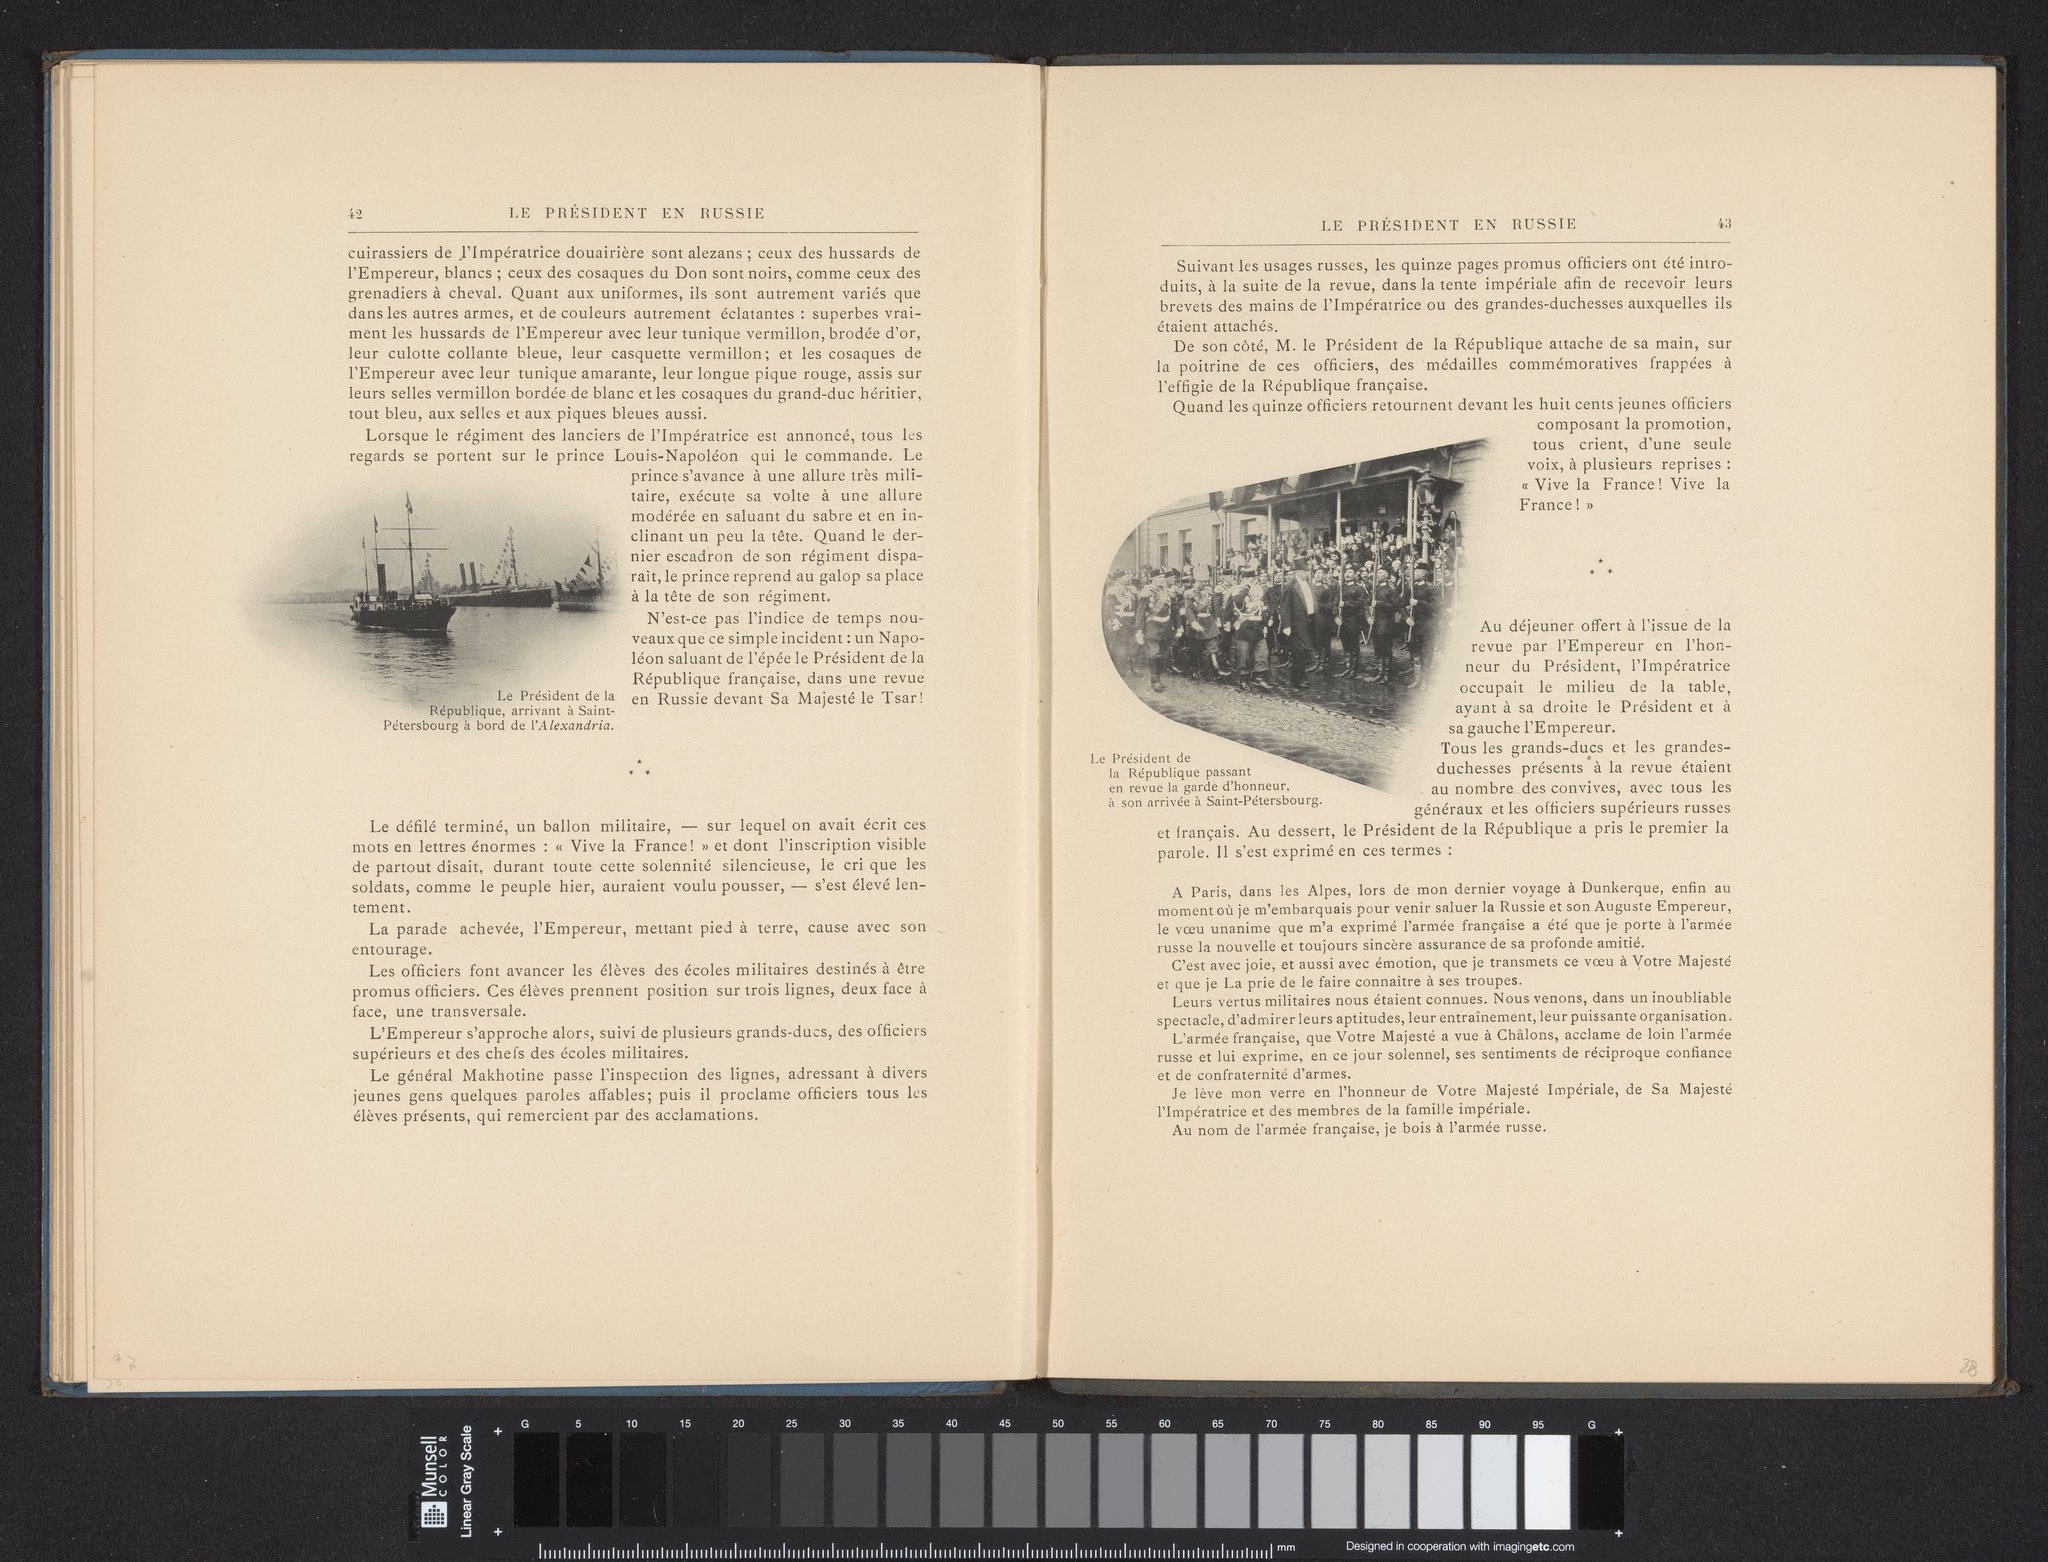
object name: photomechanical print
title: President Félix Faure inspecteert de erewacht bij zijn aankomst in Sint-Petersburg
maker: Anonymous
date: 1897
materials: paper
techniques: photograph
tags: guard of honour, ruler, sovereign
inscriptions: inscription: ‘Le Président (...) à Saint-Pétersbourg.’